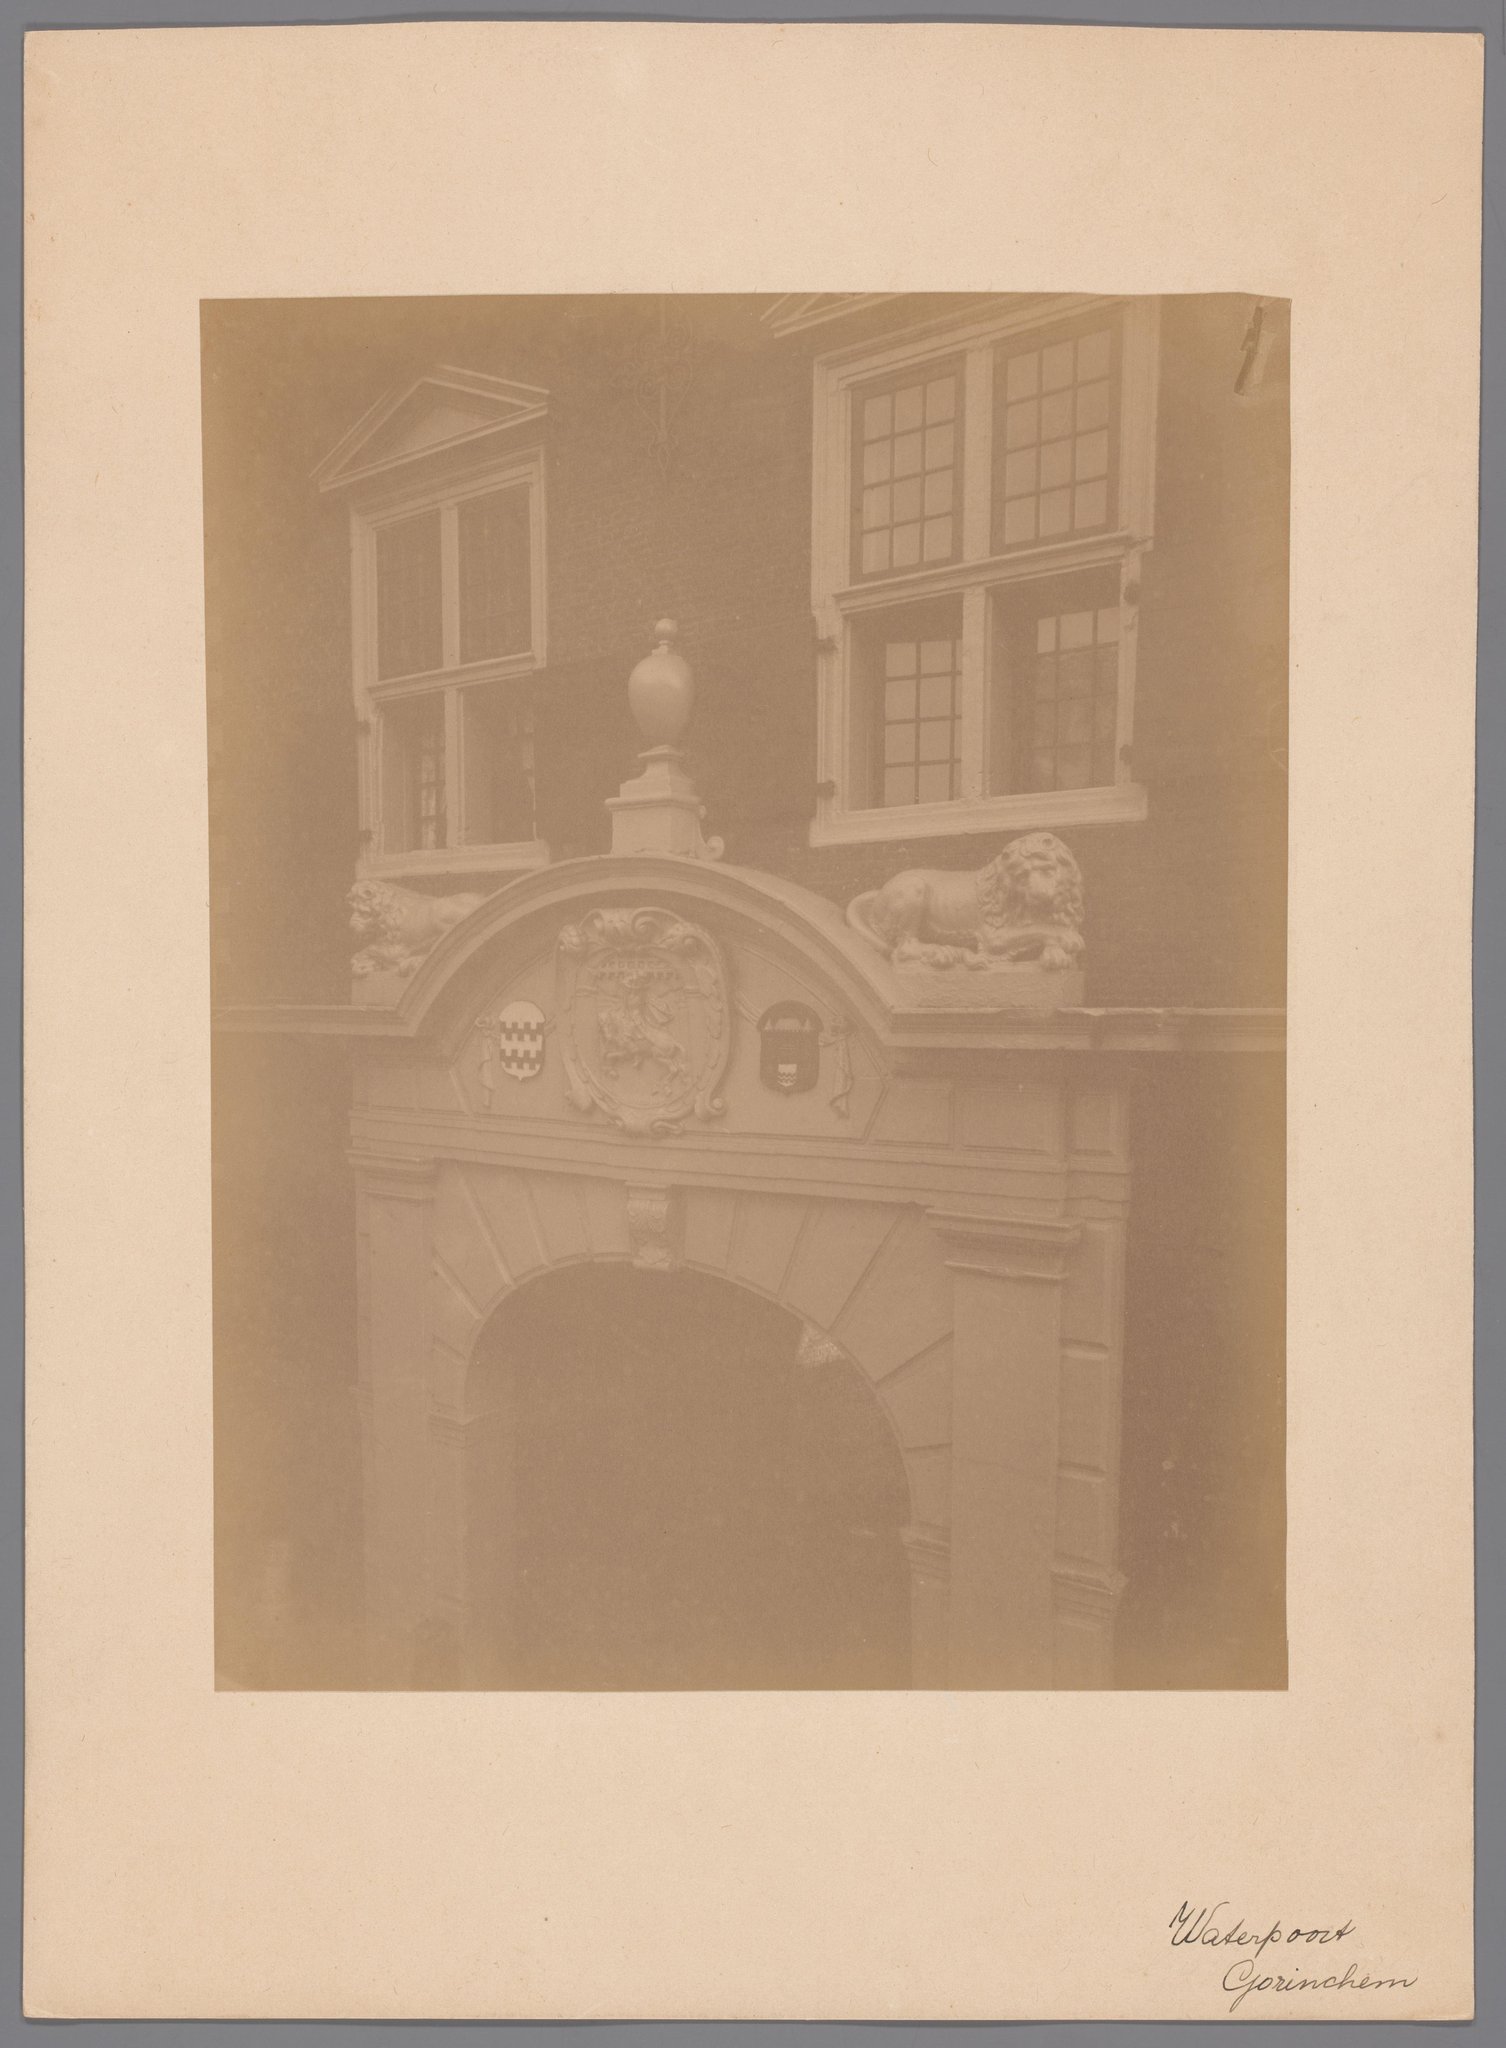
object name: photograph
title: Detail van de waterpoort te Gorinchem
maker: anoniem (monumentenzorg)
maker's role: fotograaf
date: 1890-1915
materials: cardboard, photographic support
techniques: albumen print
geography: gorinchem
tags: watergate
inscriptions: annotation: ‘Gorinchem Waterpoort’, annotation: ‘Waterpoort/ Gorinchem’